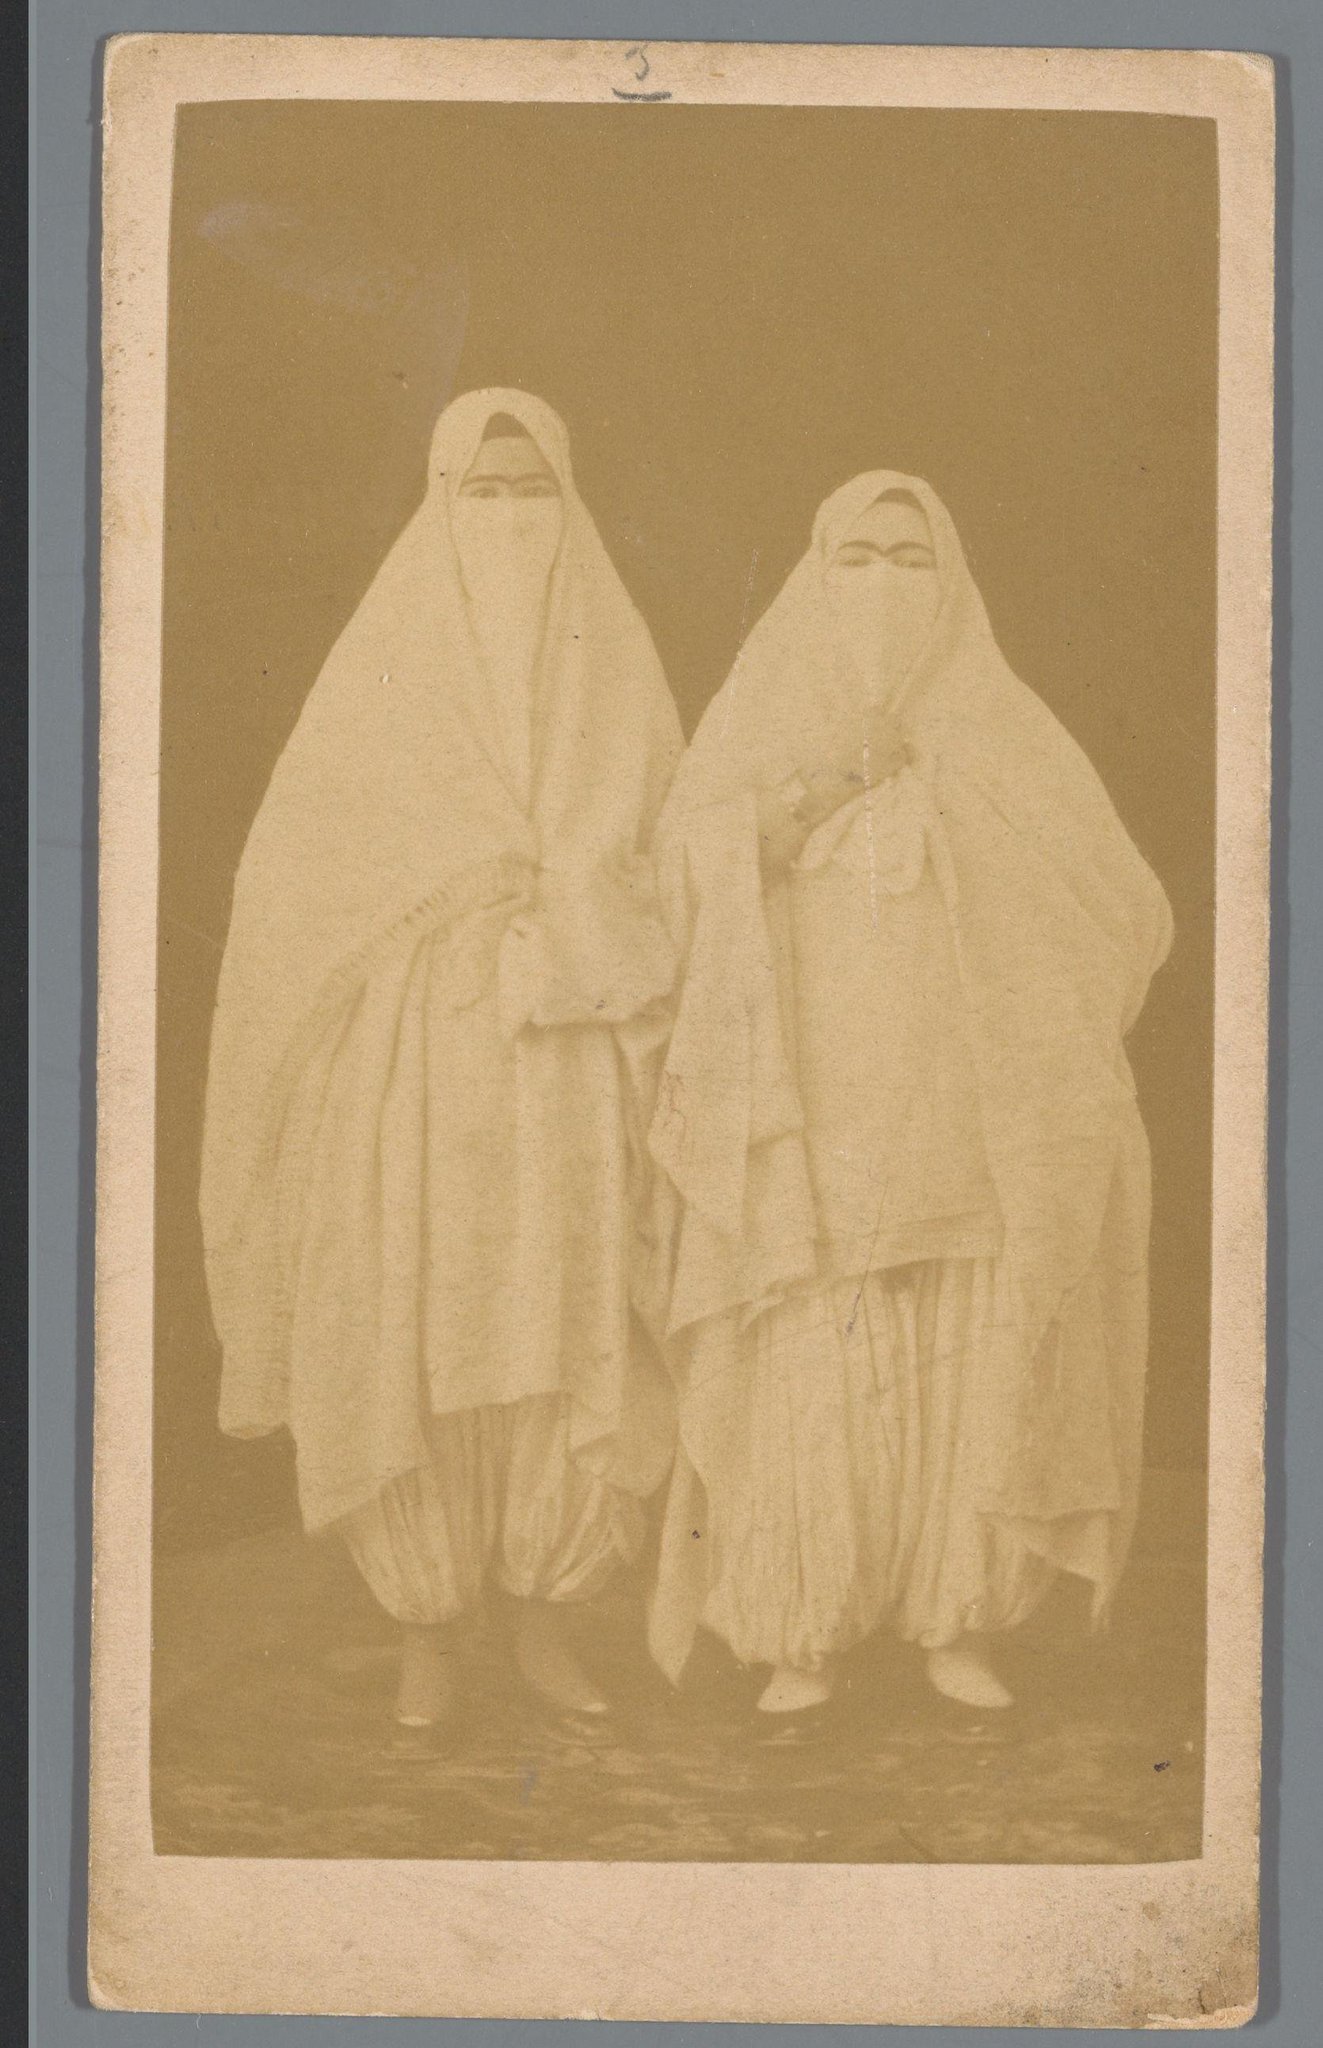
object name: carte de visite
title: Portret van twee onbekende vrouwen in nikab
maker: Anonymous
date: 1855-1885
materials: cardboard, paper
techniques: albumen print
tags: adult woman, anonymous historical person portrayed, veil